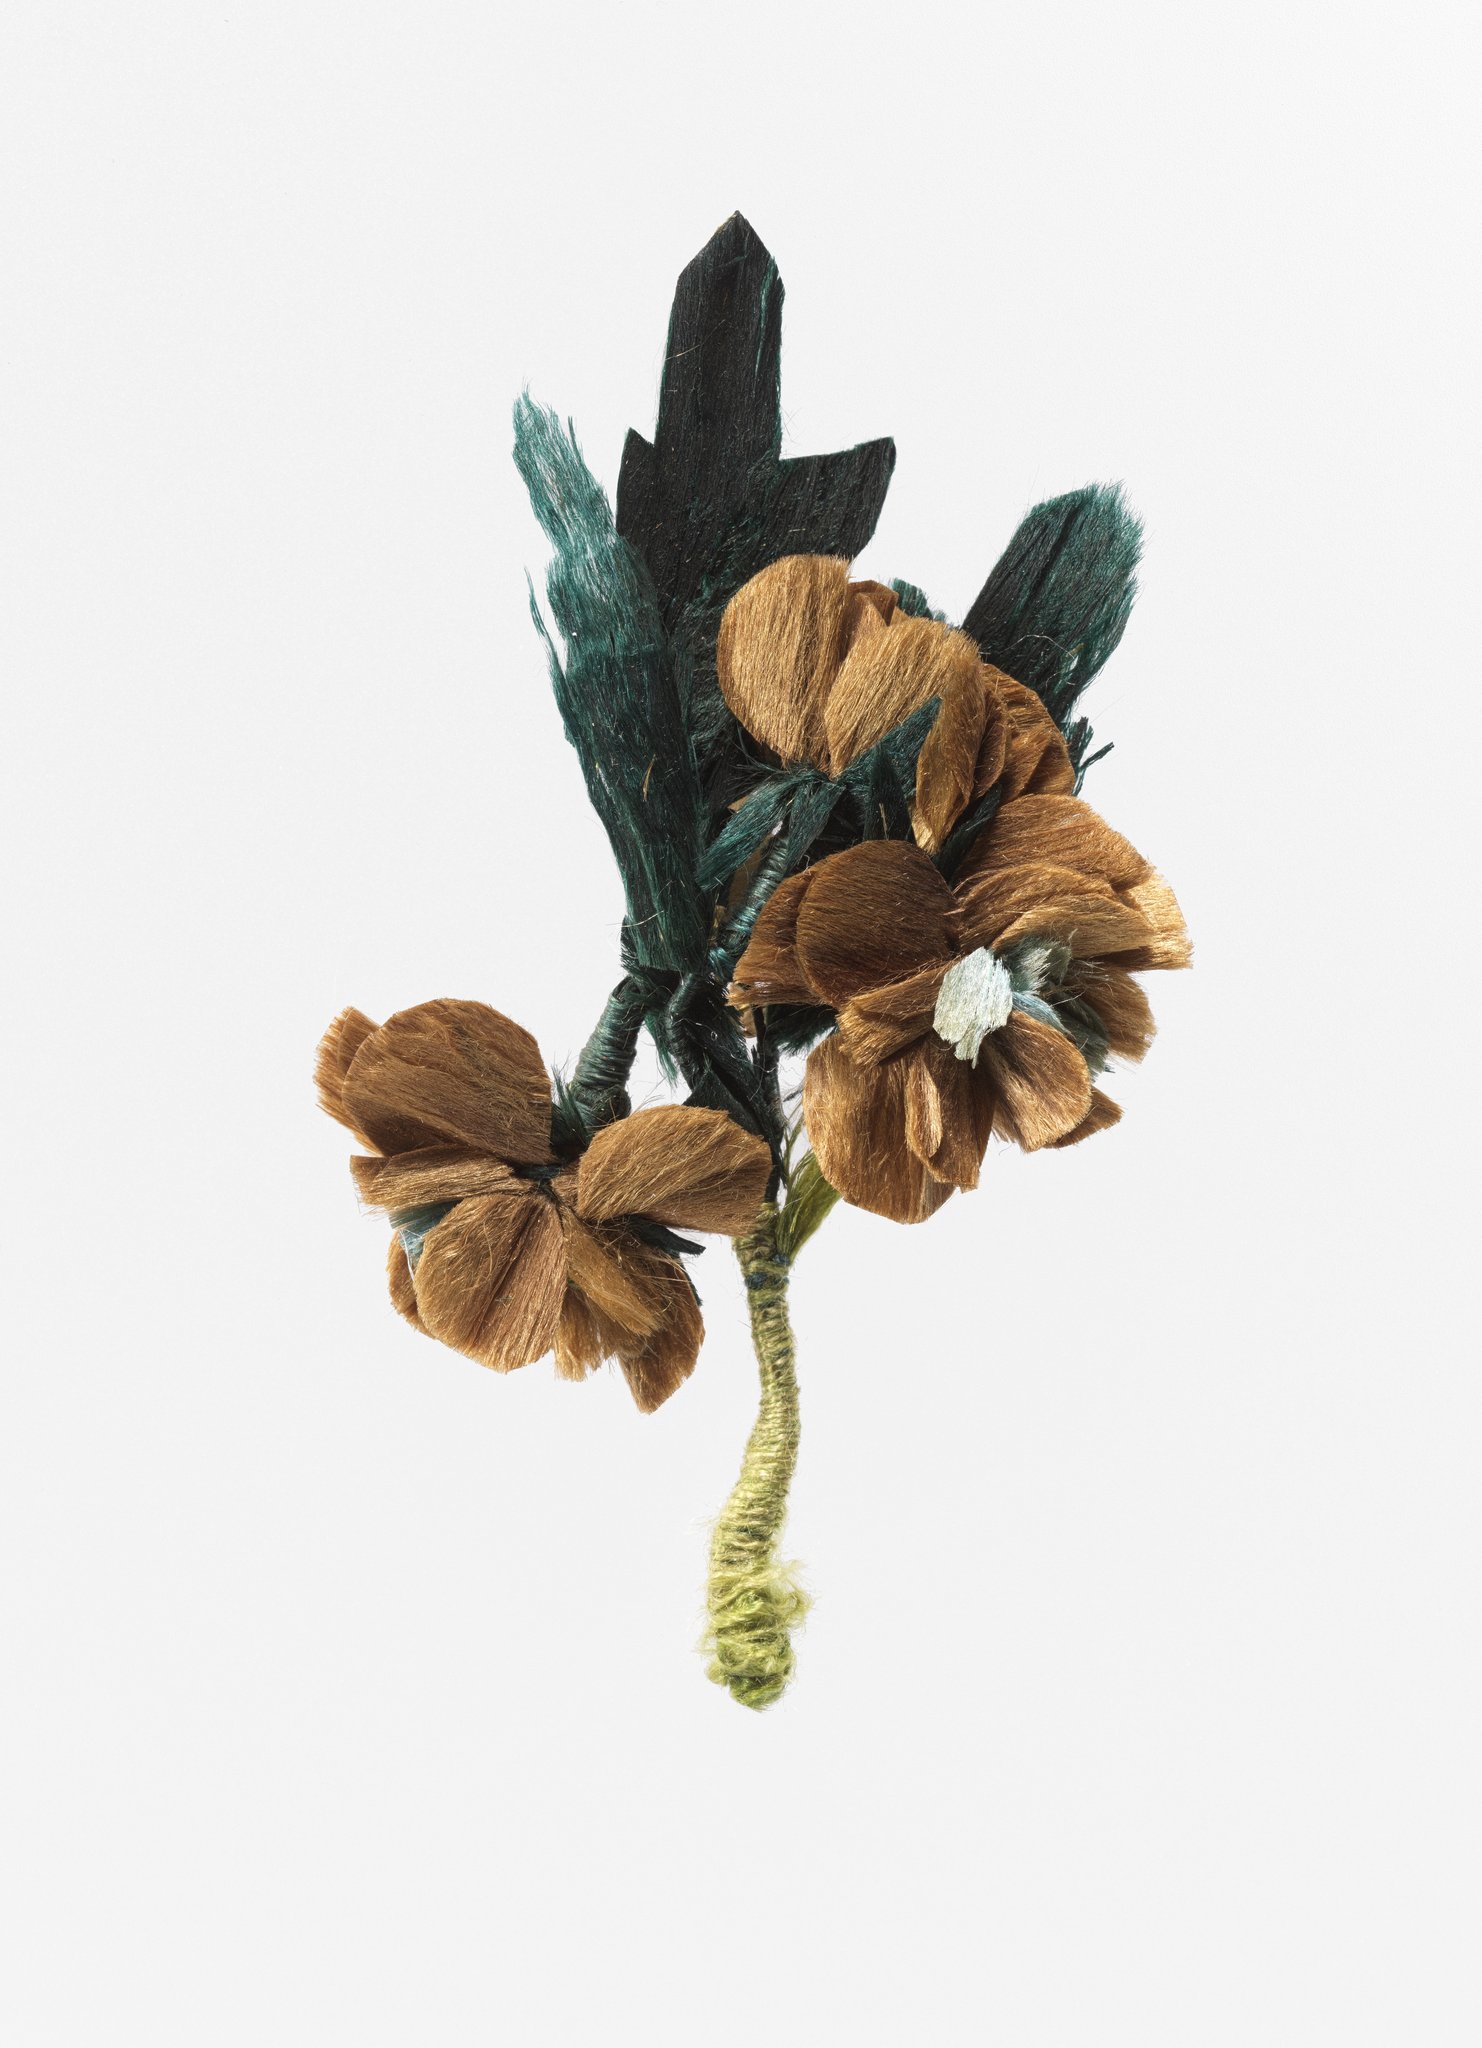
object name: boutonnière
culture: british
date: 1625-1649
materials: silk